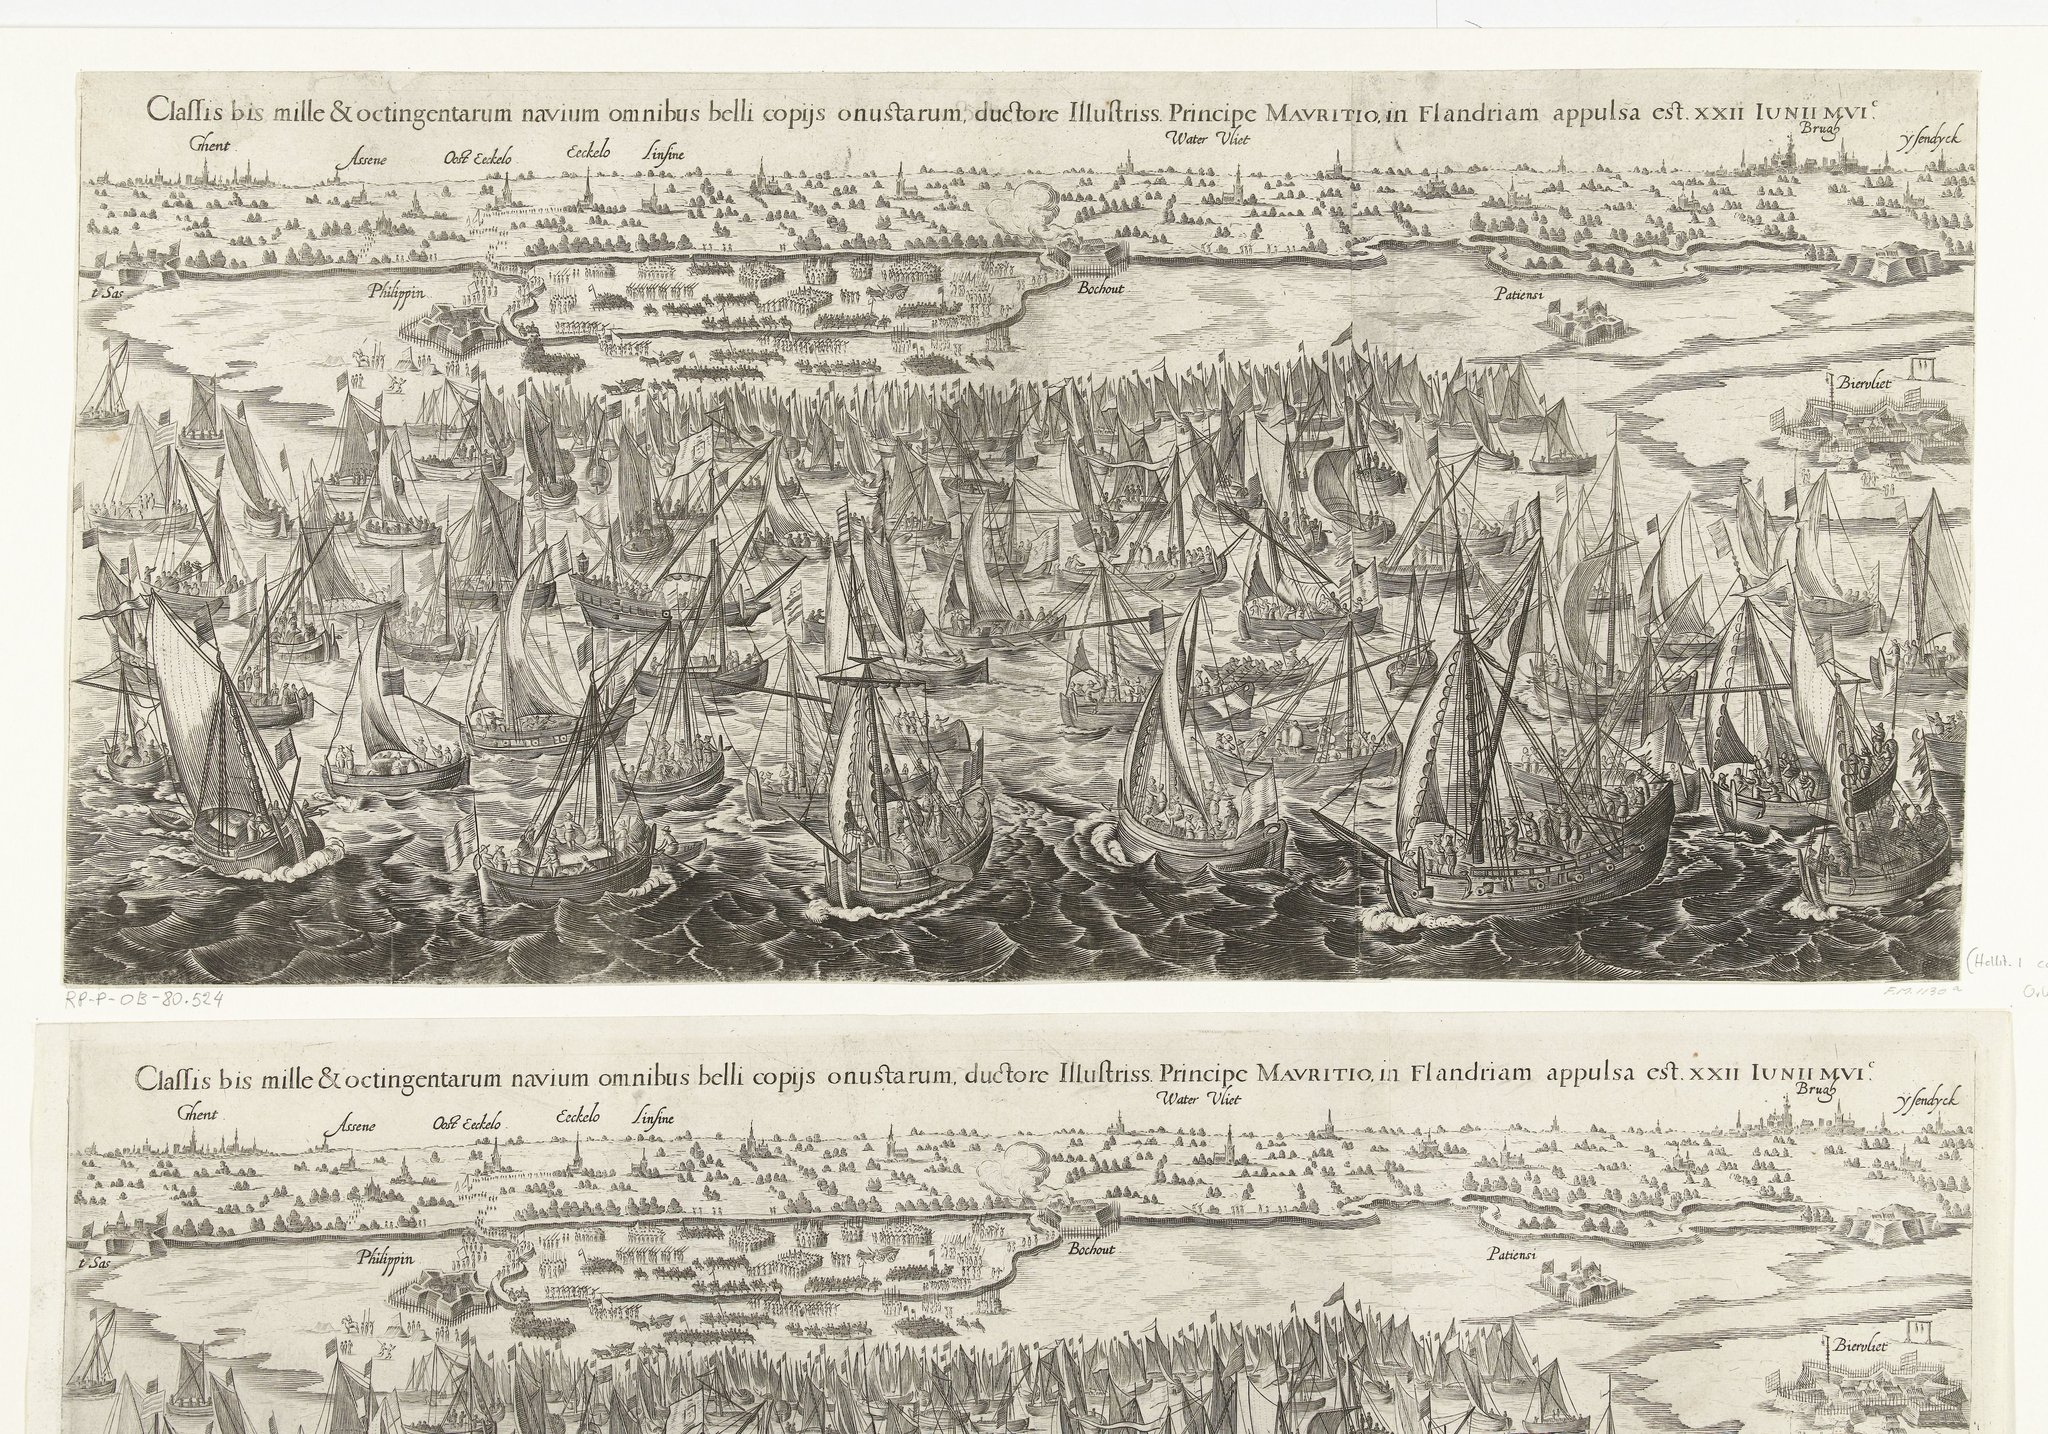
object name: print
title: Classis bis mille & octingentarum navium omnibus belli copijs onustarum ductore Illustriss. Principe Mauritio, in Flandriam appulsa est. XXII Junii MVIC.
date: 1610-1624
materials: paper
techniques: engraving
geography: northern netherlands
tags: the hague, maurice (prince of orange), troop movements, transportation (+ sailing-ships)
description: De vlootlanding bij Philippine. De Staatse vloot van Maurits voor Philippine waar manschappen aan boord worden genomen, 22 juni 1600. Tocht naar Oostende van het Staatse leger, 19-27 juni, 1600.